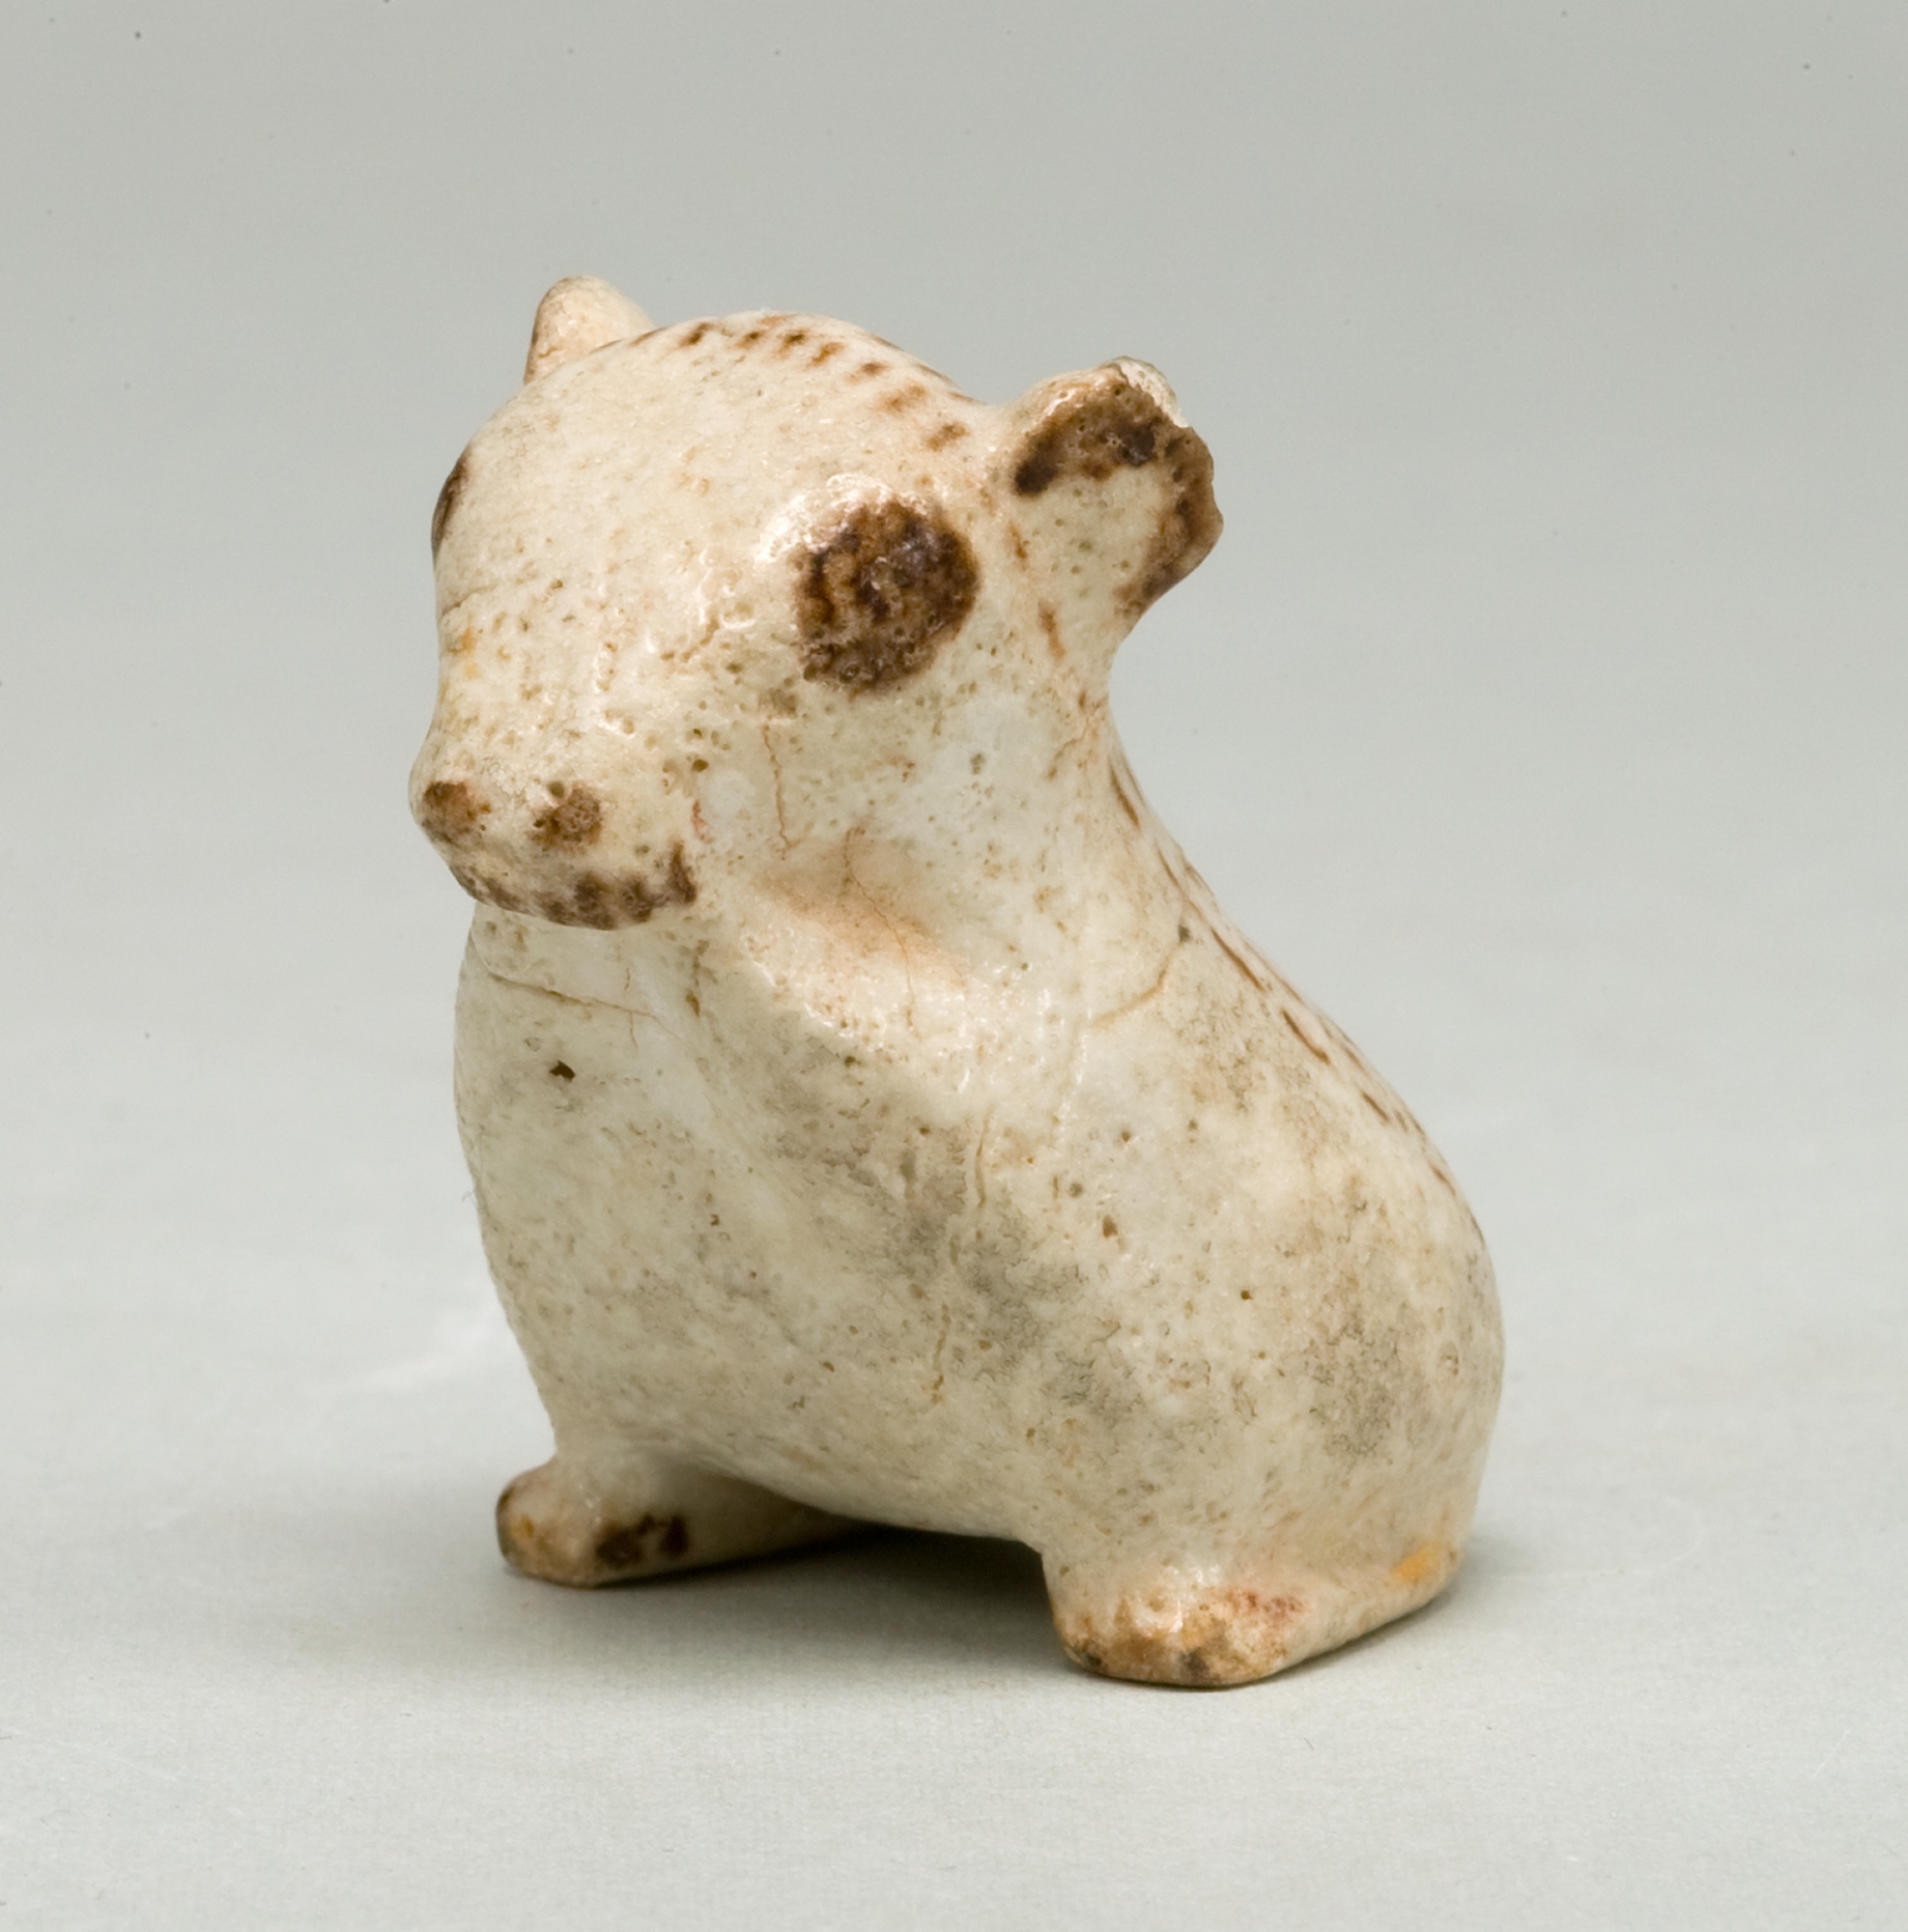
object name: figurine, jerboa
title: Jerboa figurine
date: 1850-1640 BCE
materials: faience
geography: memphite region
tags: animals